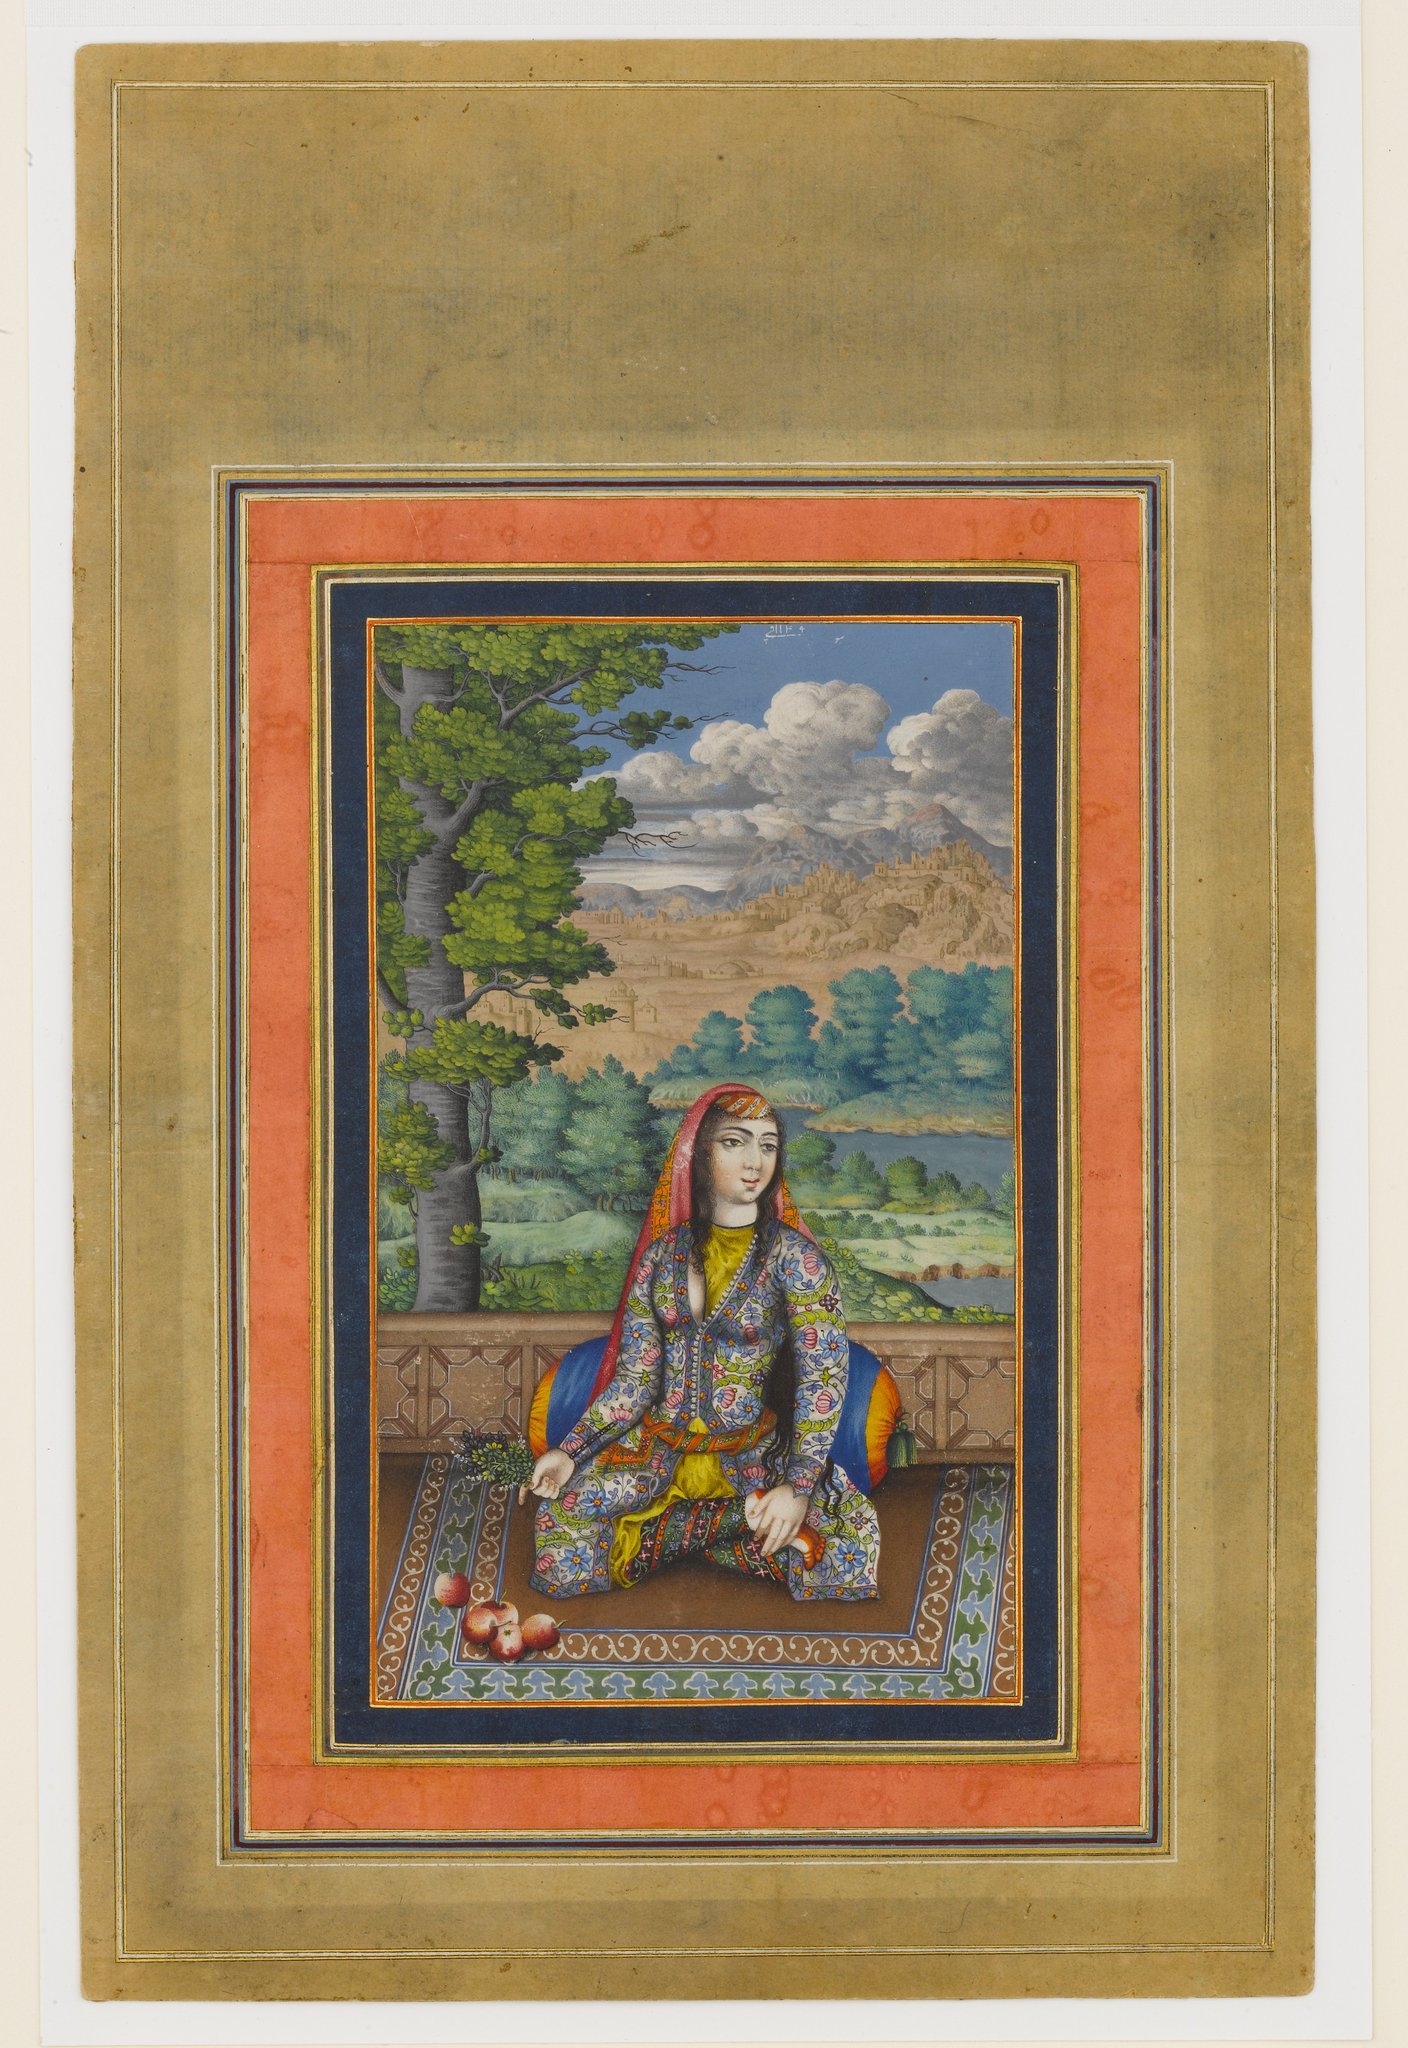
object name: illustrated album leaf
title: "Portrait of a Persian Lady", Folio from the Davis Album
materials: gold, ink, paper, watercolor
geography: iran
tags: portraits,women,landscapes